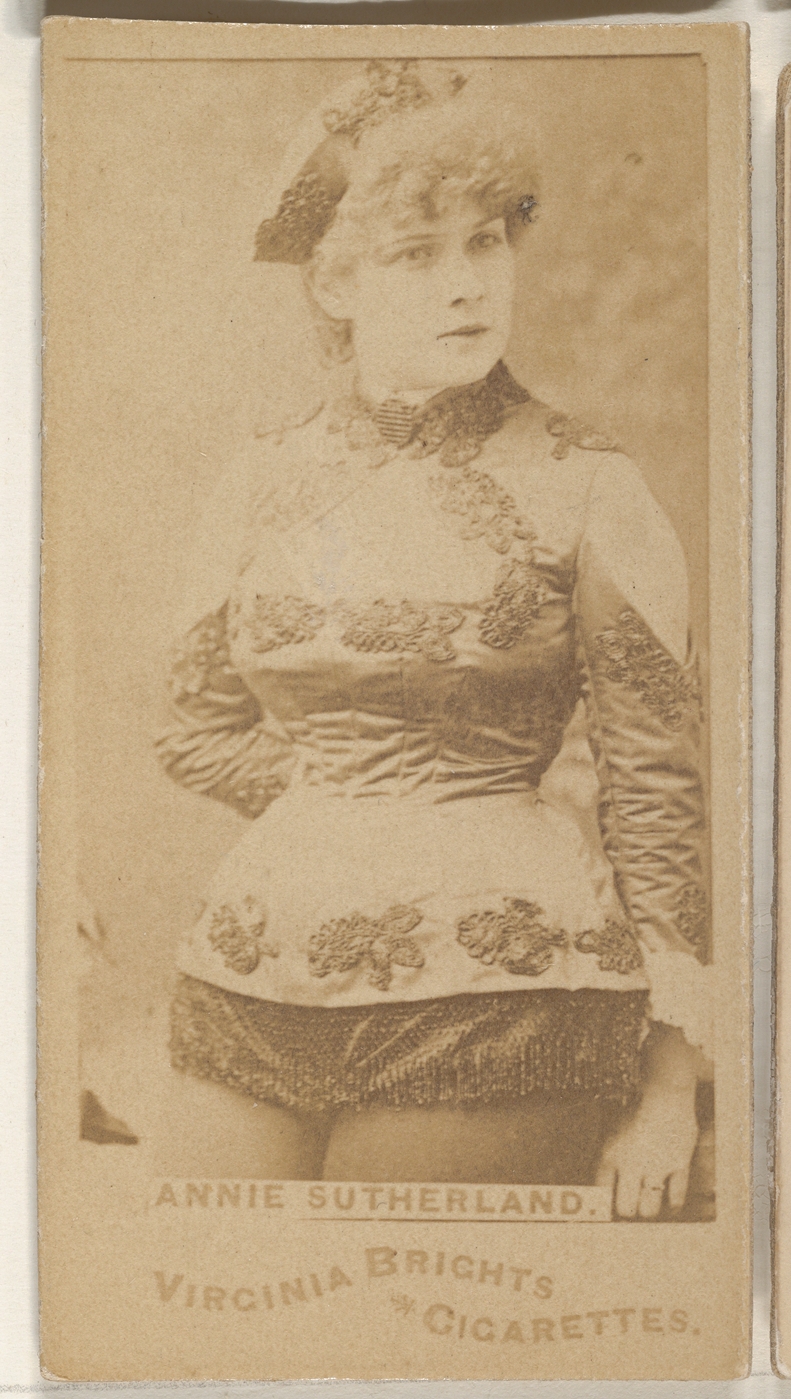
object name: photograph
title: Annie Sutherland, from the Actors and Actresses series (N45, Type 1) for Virginia Brights Cigarettes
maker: allen & ginter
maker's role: publisher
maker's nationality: american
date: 1888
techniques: albumen silver print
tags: portraits,women,actresses